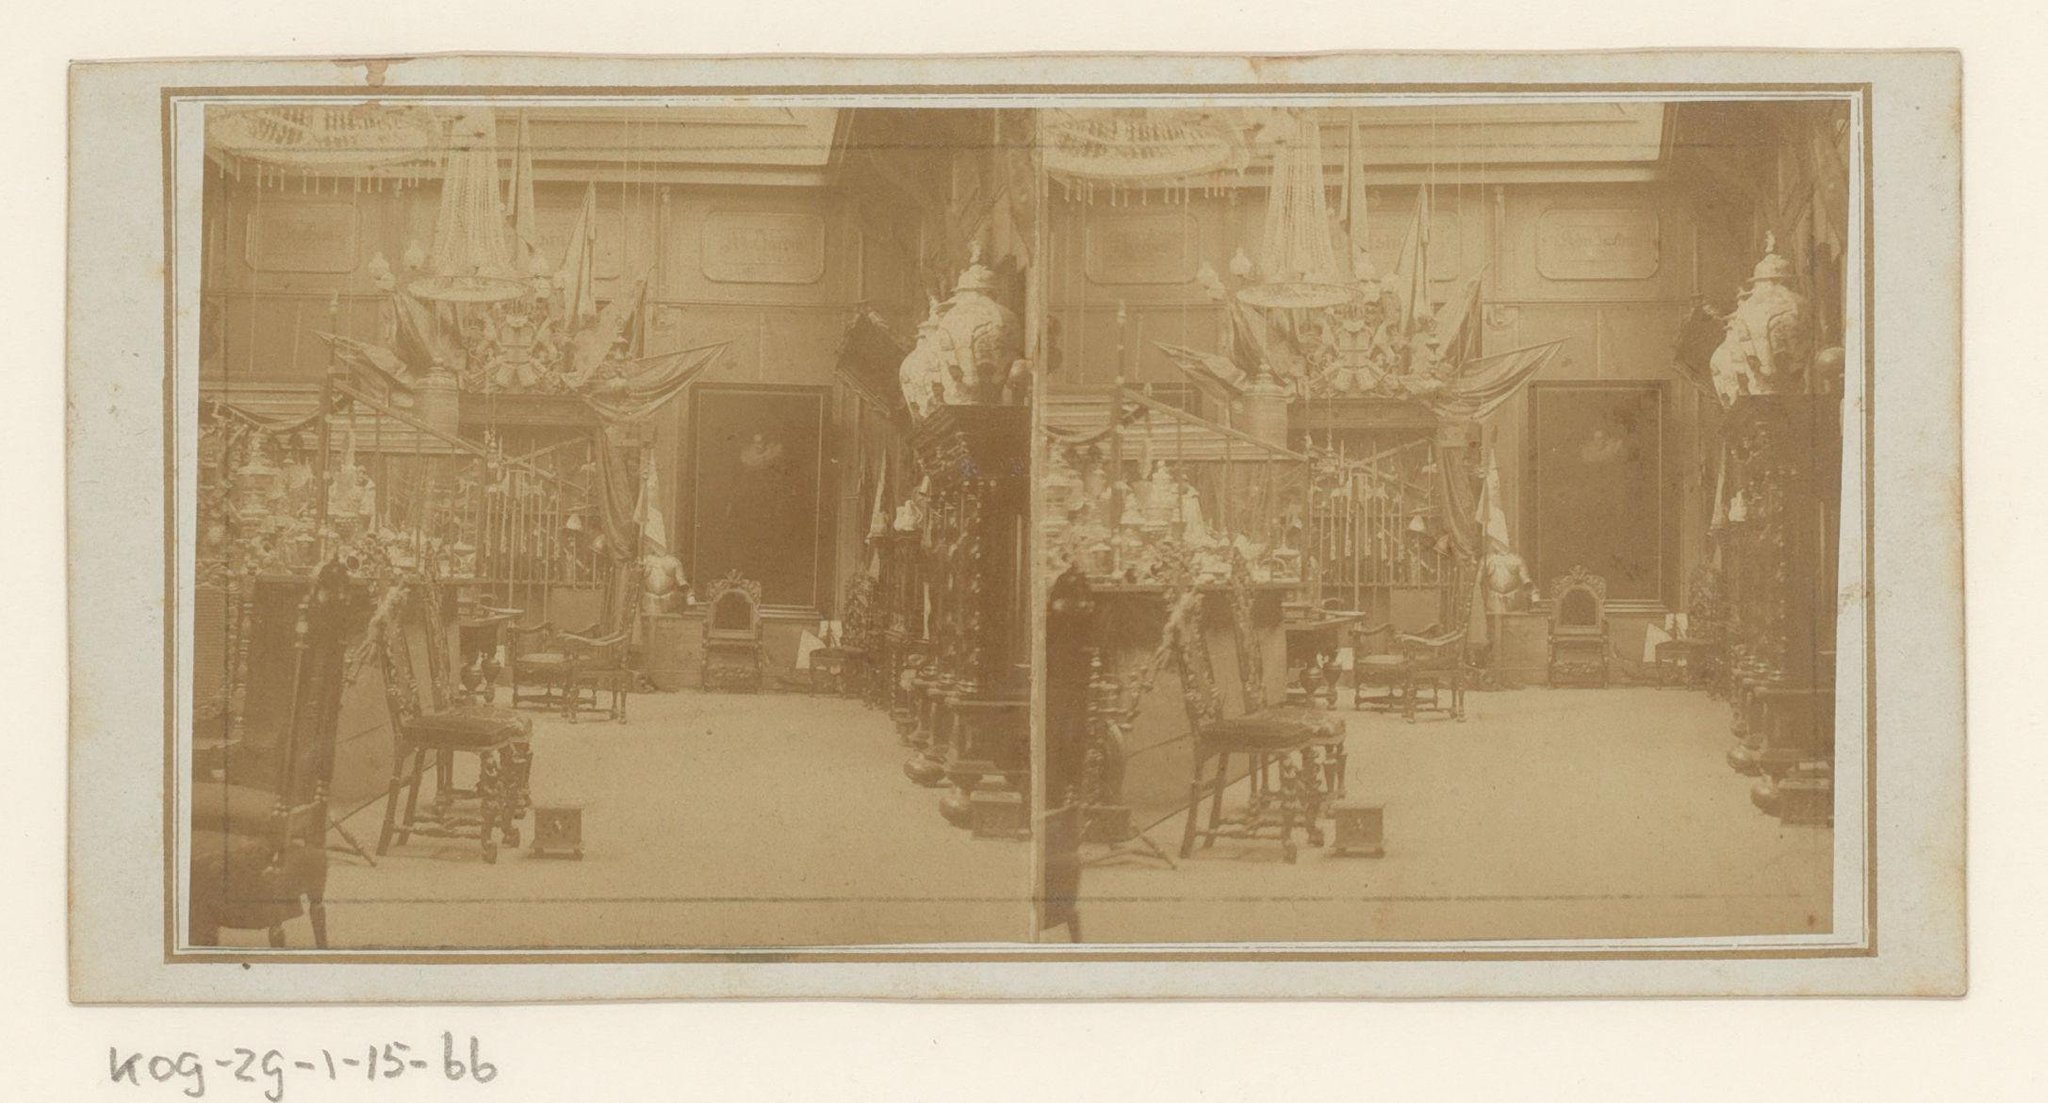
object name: photograph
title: Tentoonstelling van Oudheden in Arti et Arti et Amicitiae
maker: Anonymous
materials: cardboard, paper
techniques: albumen print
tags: collection, exhibition, show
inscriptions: stamp, collector's mark: Lugt 1641, stamp, collector's mark: Lugt 963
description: Onderwerpsrubrieken binnen de Atlas Zeden en Gewoonten: Handel, nijverheid en verkeer, Tentoonstellingen.